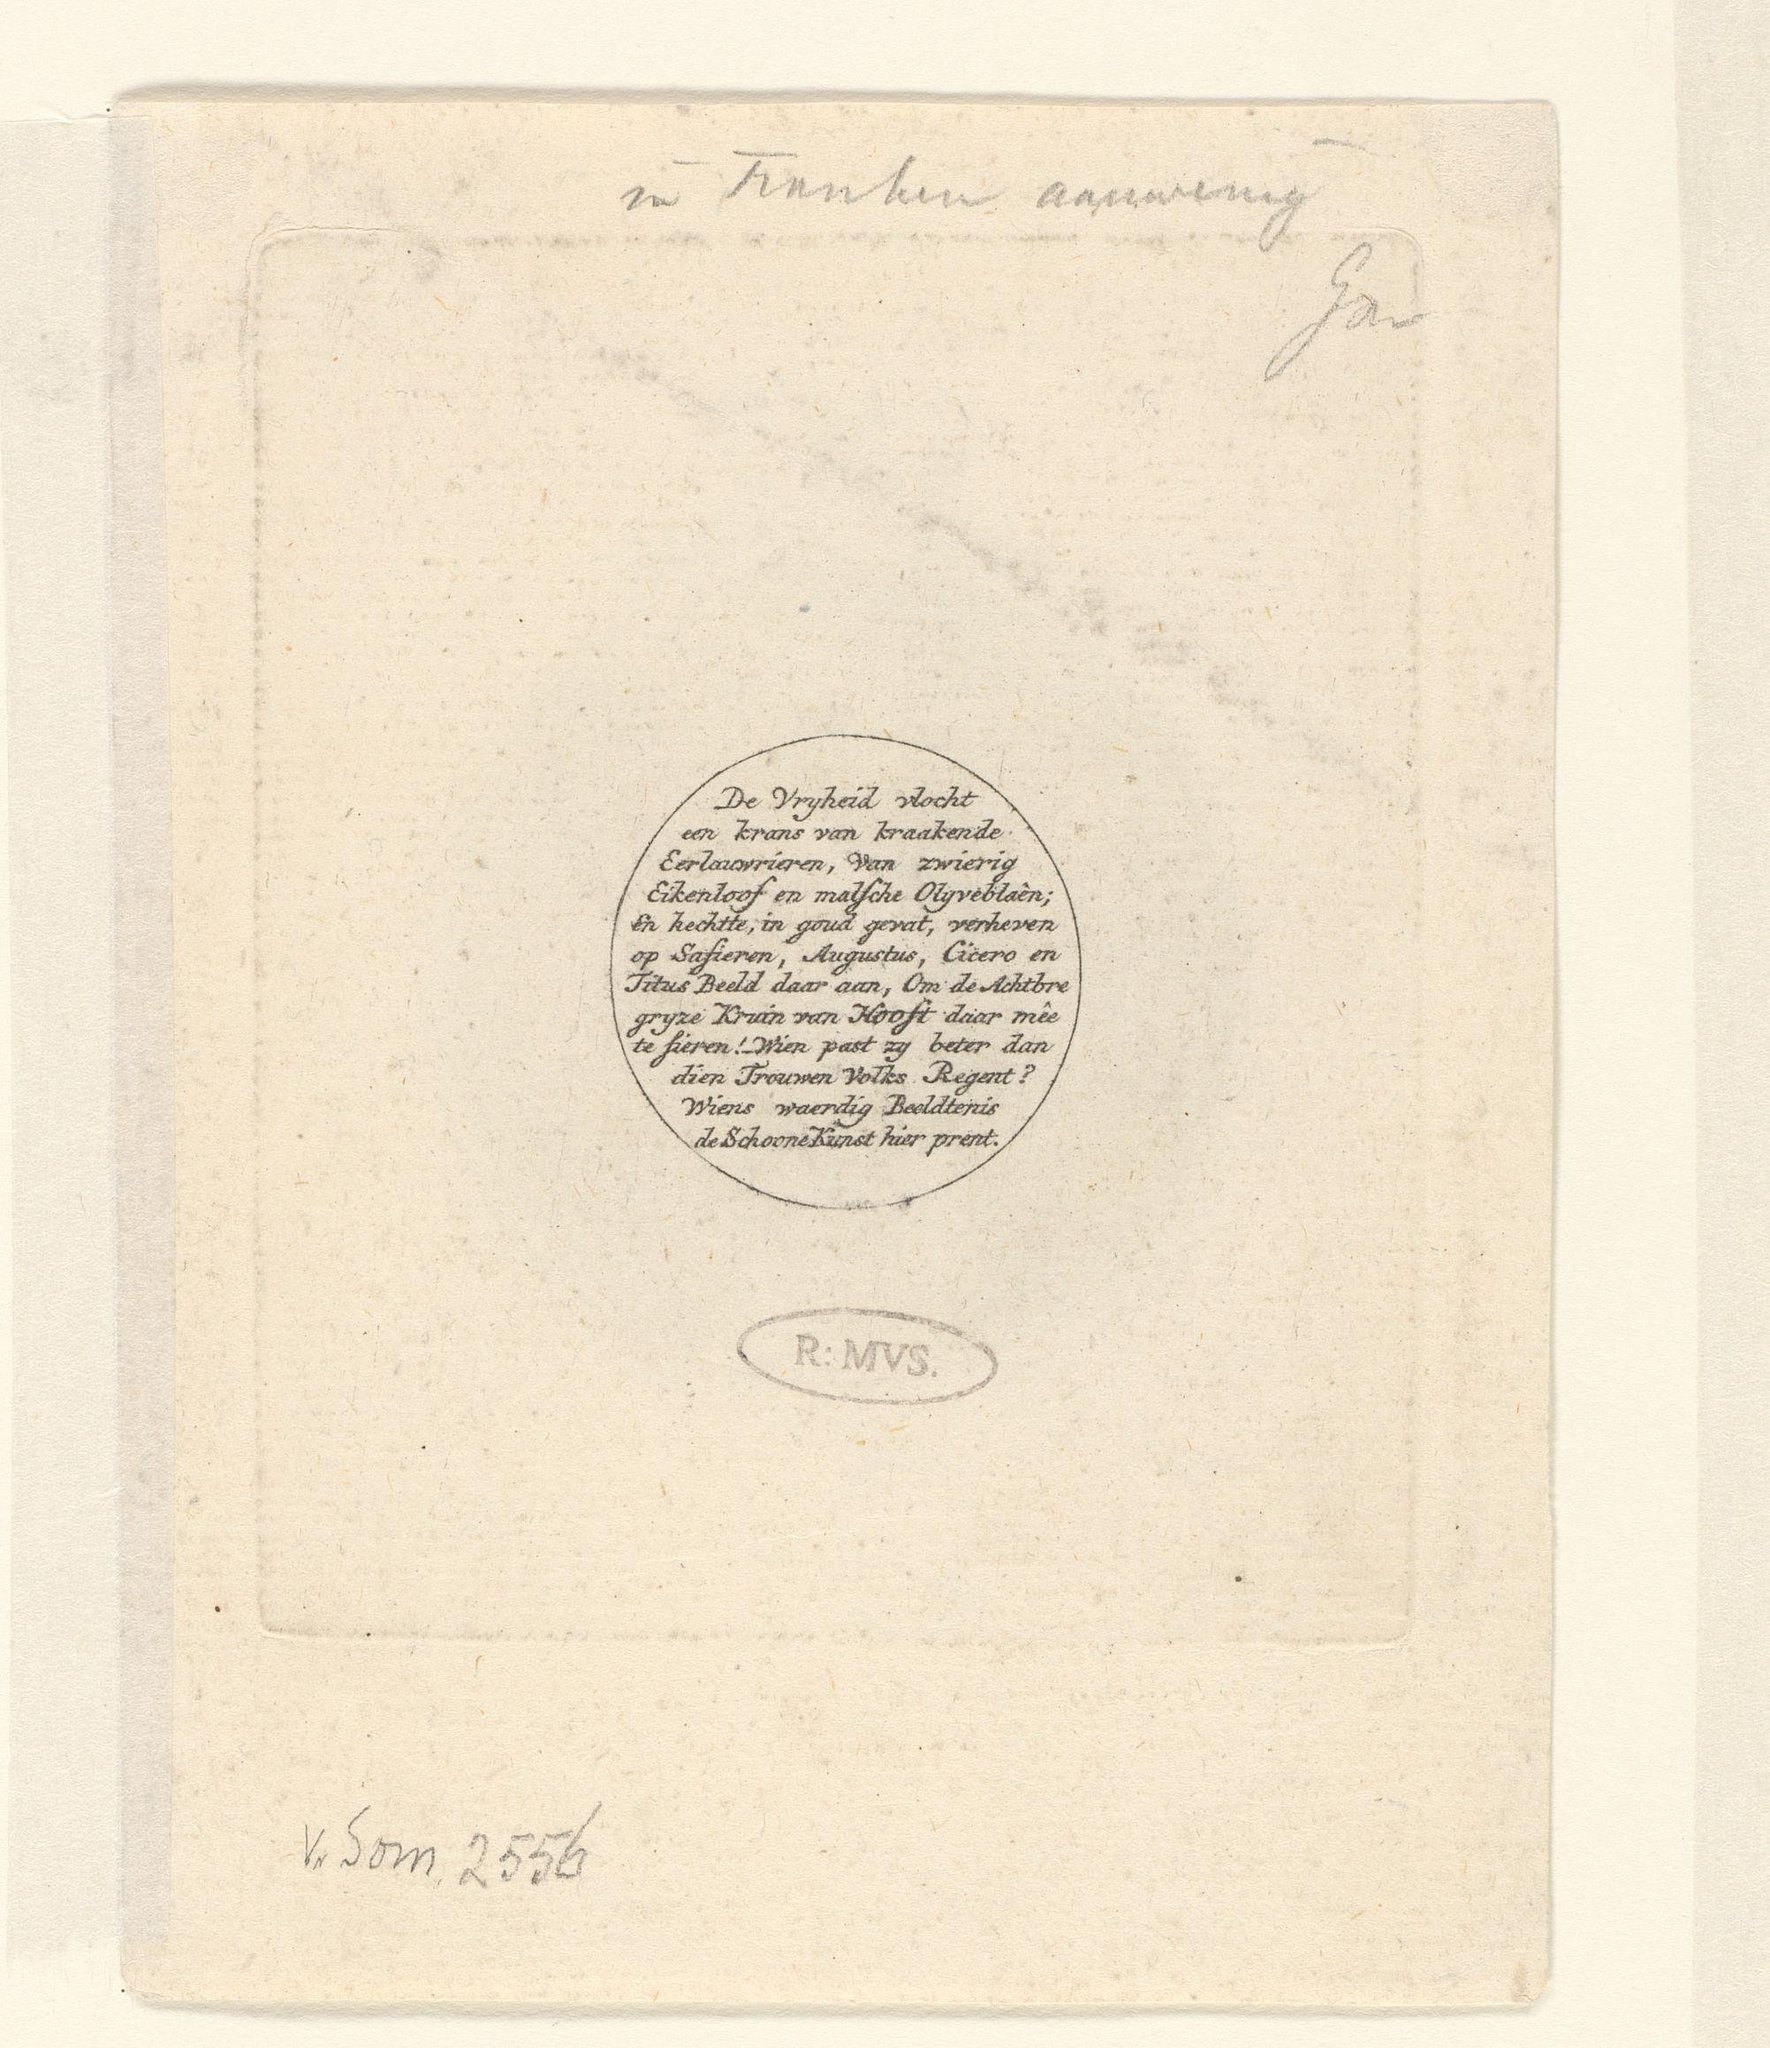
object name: print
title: Bijschrift bij het portret van Hendrik Danielsz. Hooft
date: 1774-1797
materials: paper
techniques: engraving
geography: amsterdam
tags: amsterdam, mayor, hendrik danielsz. hooft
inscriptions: collector's mark: Lugt 2228